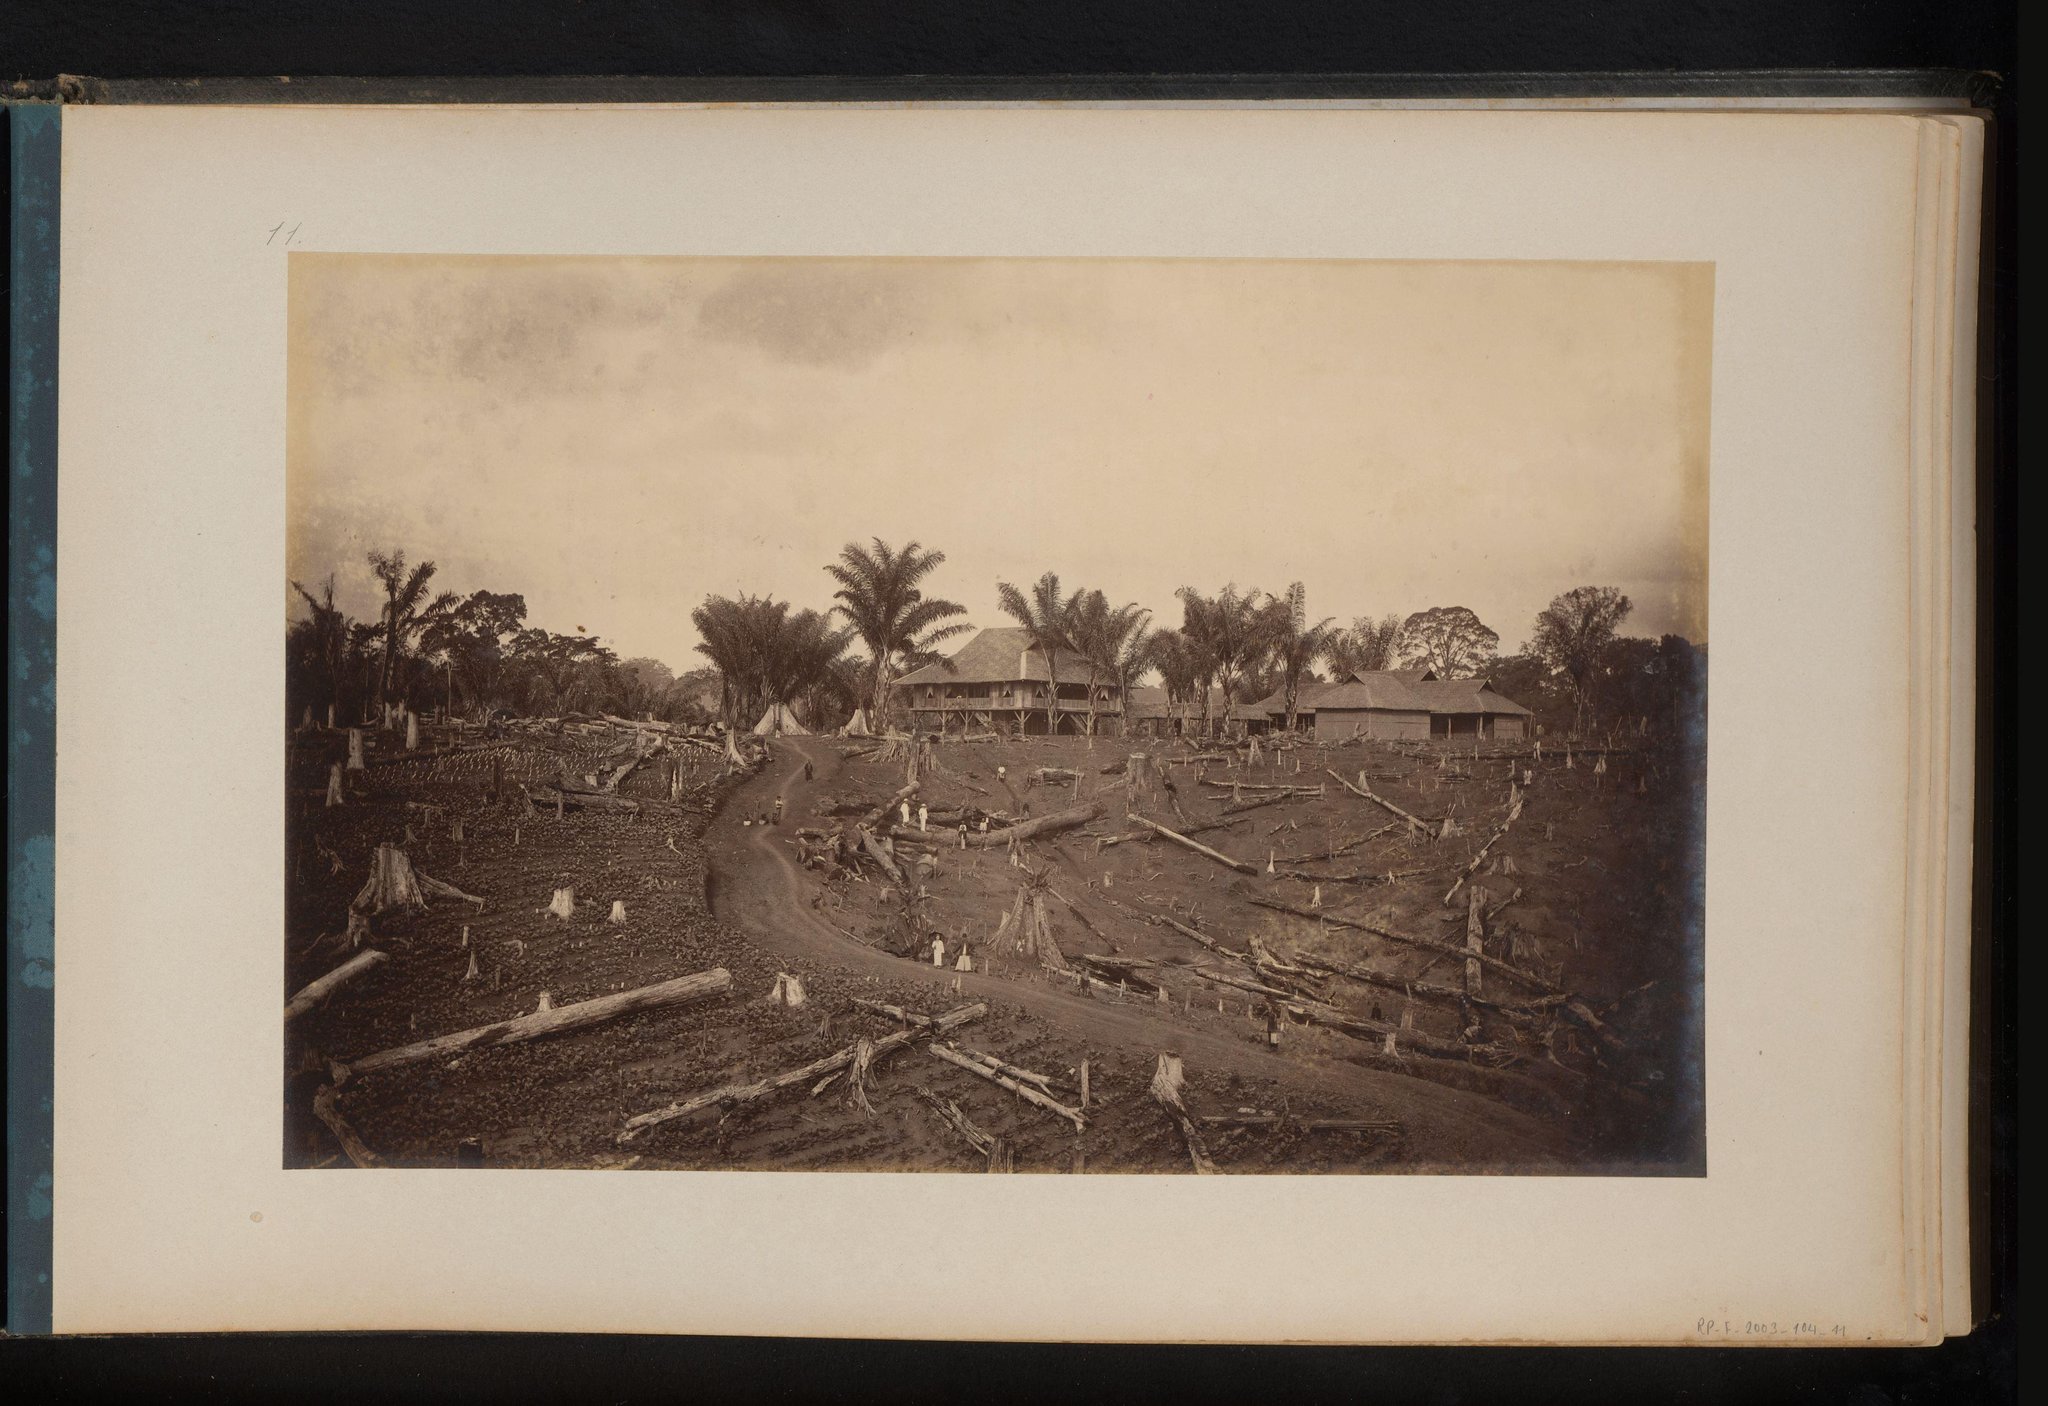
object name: photograph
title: Gezicht op het terrein rondom de administrateurswoning in Soengei-Roean, Sumatra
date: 1890-1900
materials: cardboard, photographic support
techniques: albumen print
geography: sumatra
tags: plantation, woodcutting, woodcutter ~ forestry, jungle, hut, cabin, lodge, sumatra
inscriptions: number: ‘11.’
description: In de lijst van afbeeldingen wordt deze foto beschreven met de woorden "Administrator's Haus in Soengei-Roean".